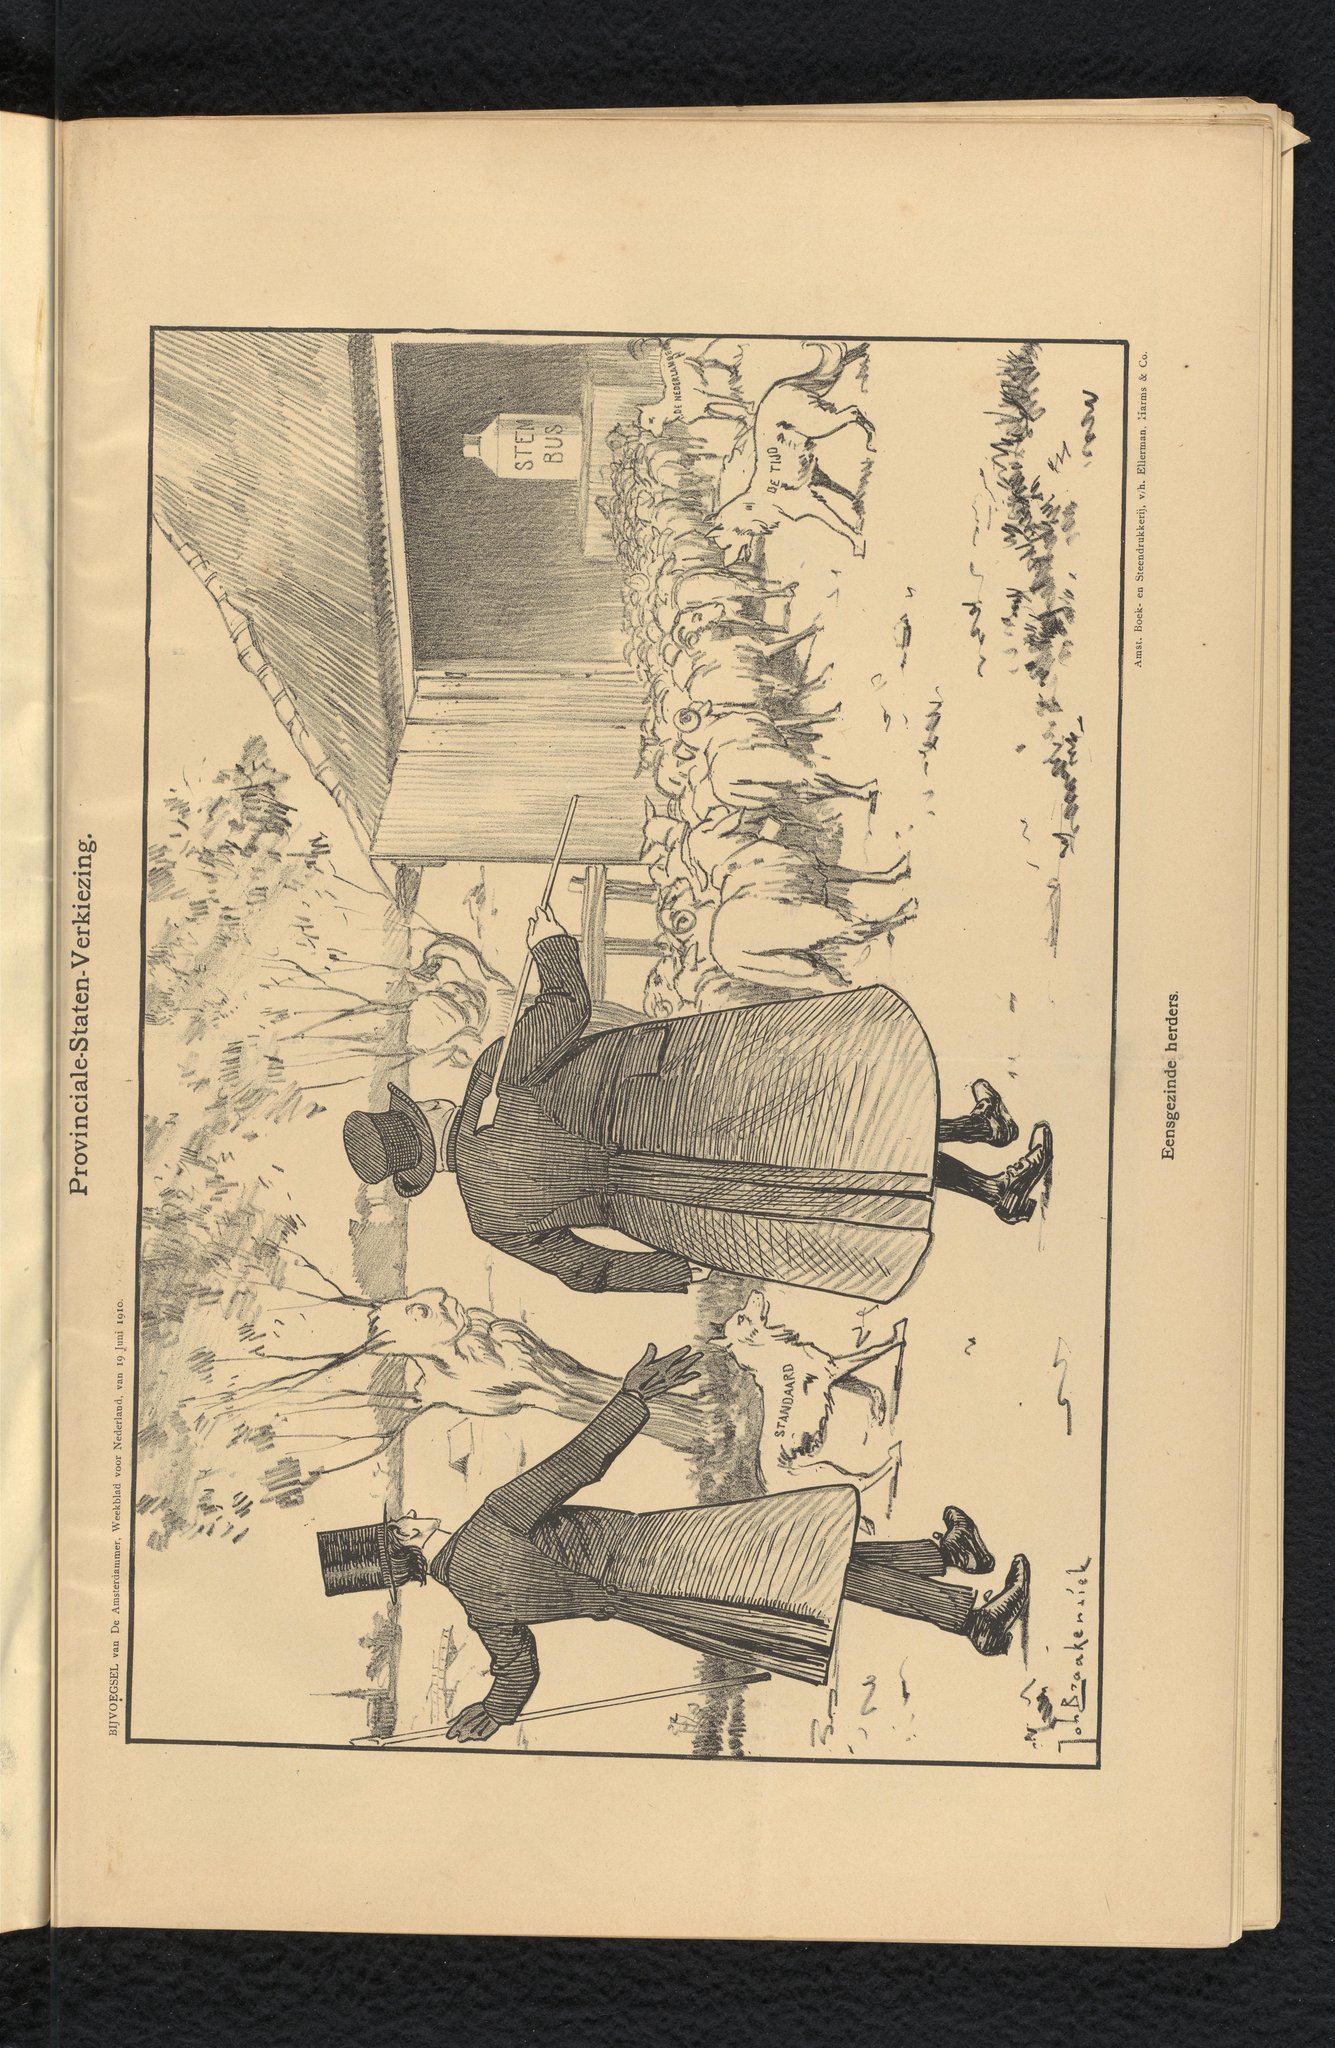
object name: cartoon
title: Provinciale-Staten-Verkiezing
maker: johan braakensiek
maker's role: draughtsman, print maker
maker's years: 1858-1940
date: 1910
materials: paper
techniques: lithograph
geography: netherlands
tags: voting, election, herding, herdsman, herdswoman, shepherd, shepherdess, cowherd, etc., political caricatures and satires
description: Partijleiders van klerikale partijen leiden als herders hun kudde schapen naar de stembus voor de aanstaande verkiezing voor de Provinciale Staten. Met de christelijke kranten De Standaard en De Tijd als herdershonden.